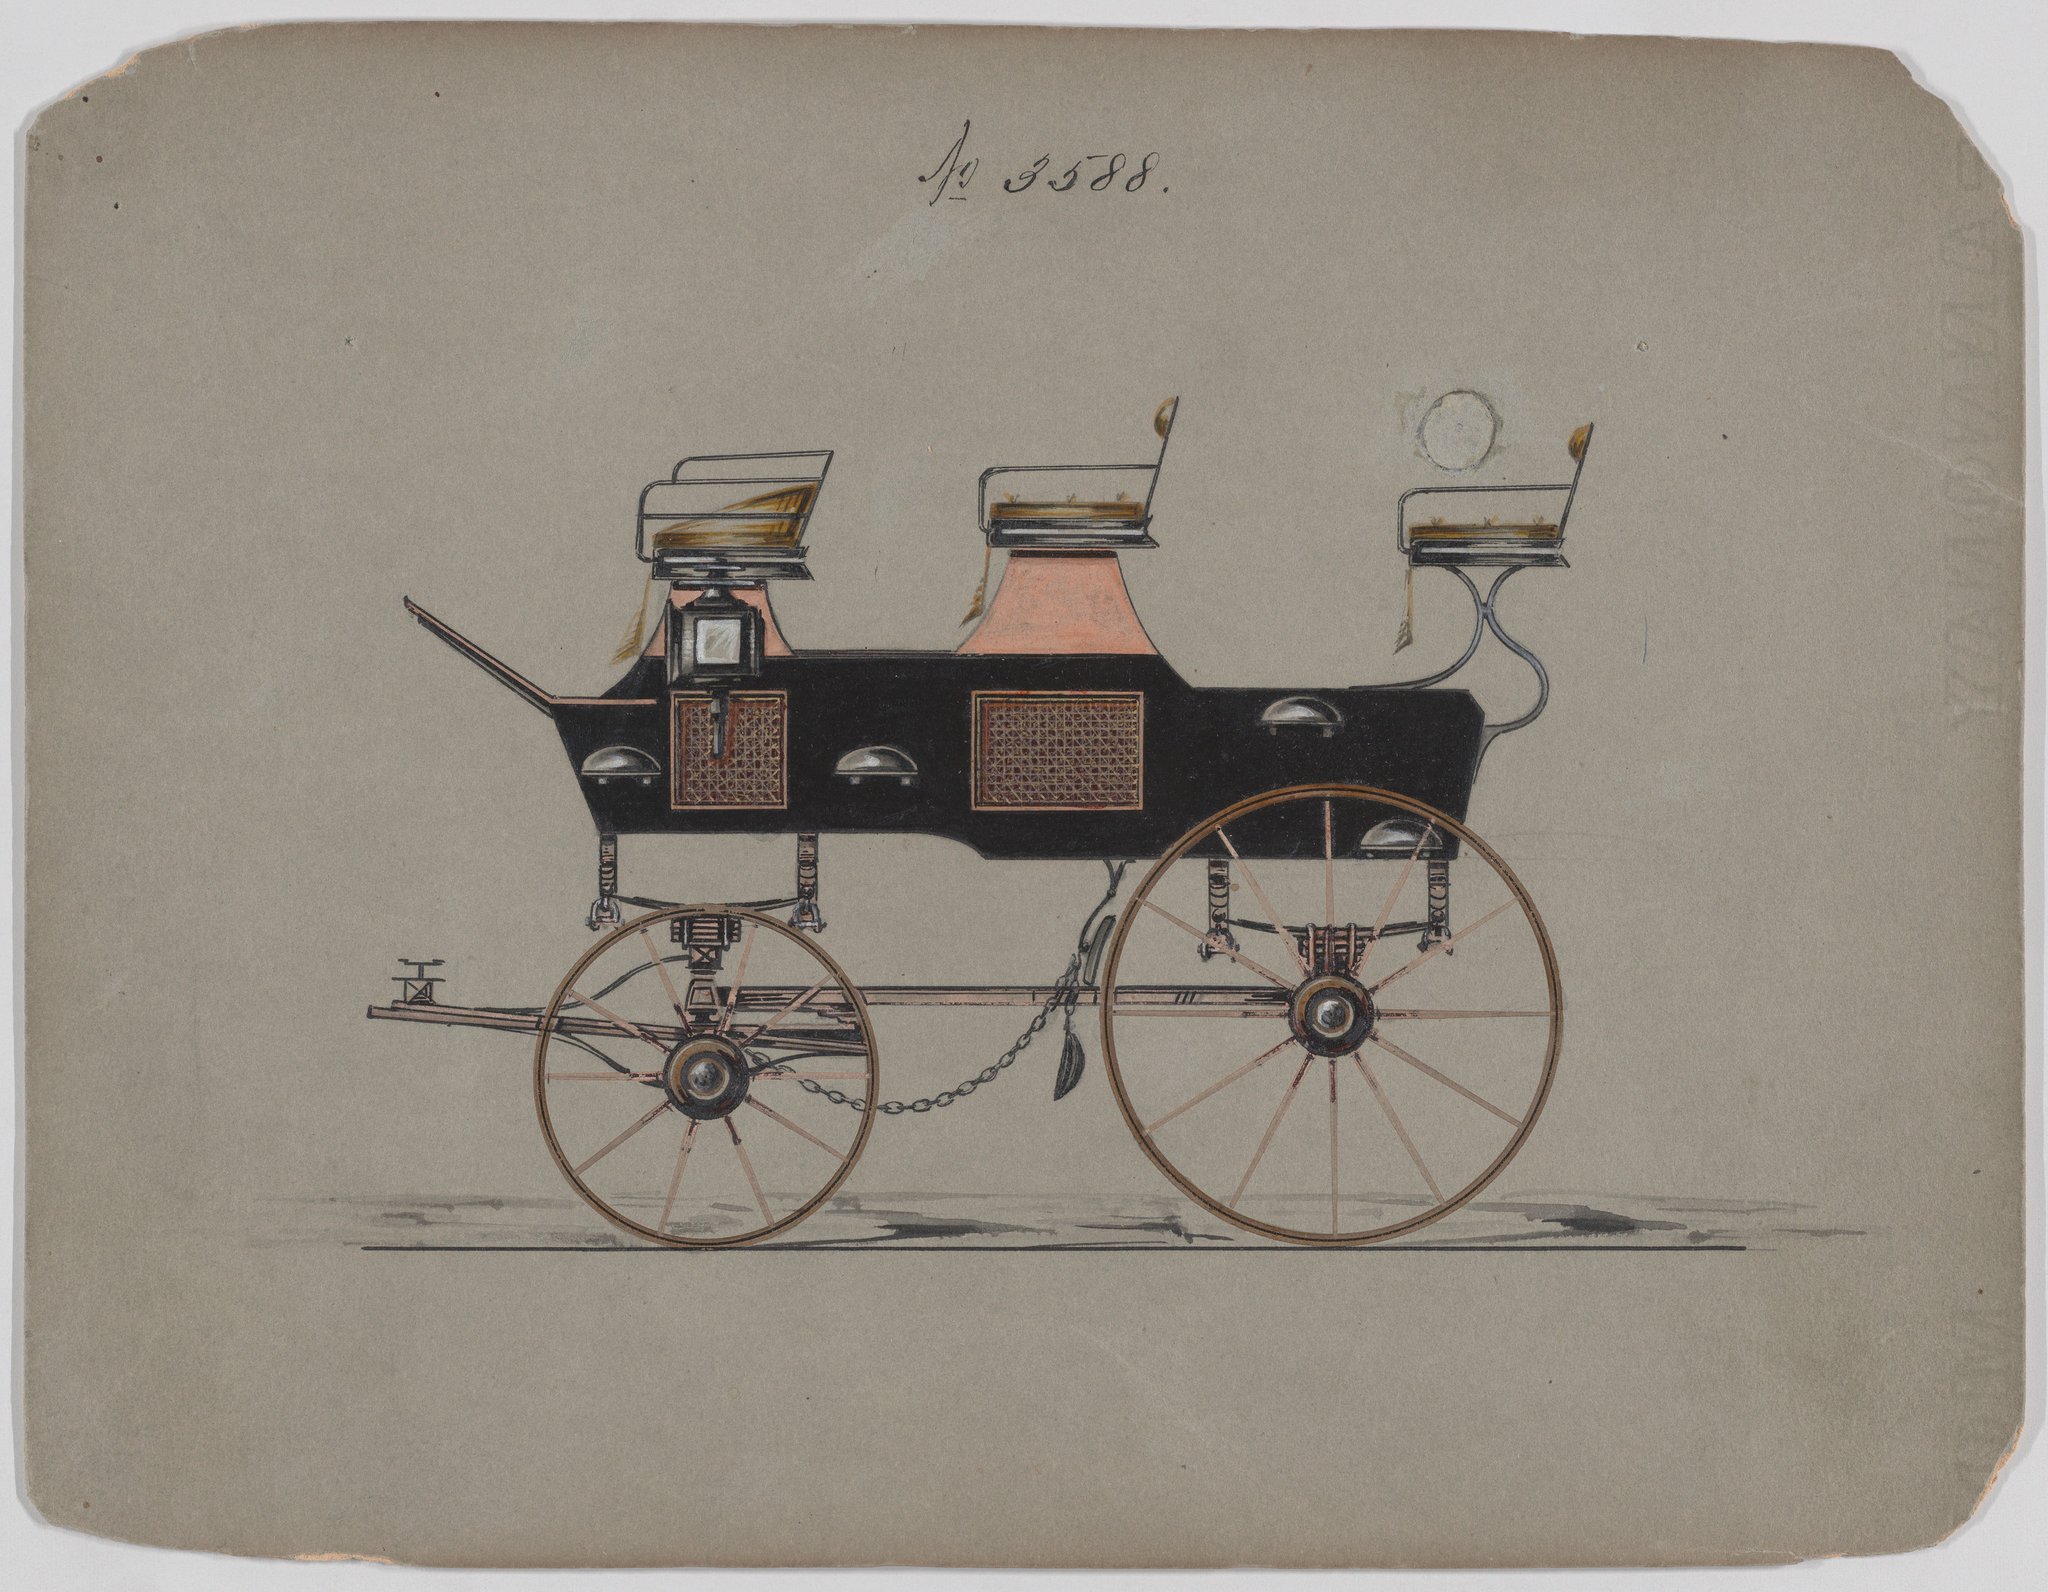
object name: drawing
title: Roof Seat Break #3588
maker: brewster & co.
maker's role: manufacturer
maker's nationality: american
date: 1880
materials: gouache, gum arabic, ink, watercolor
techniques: pen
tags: carriages